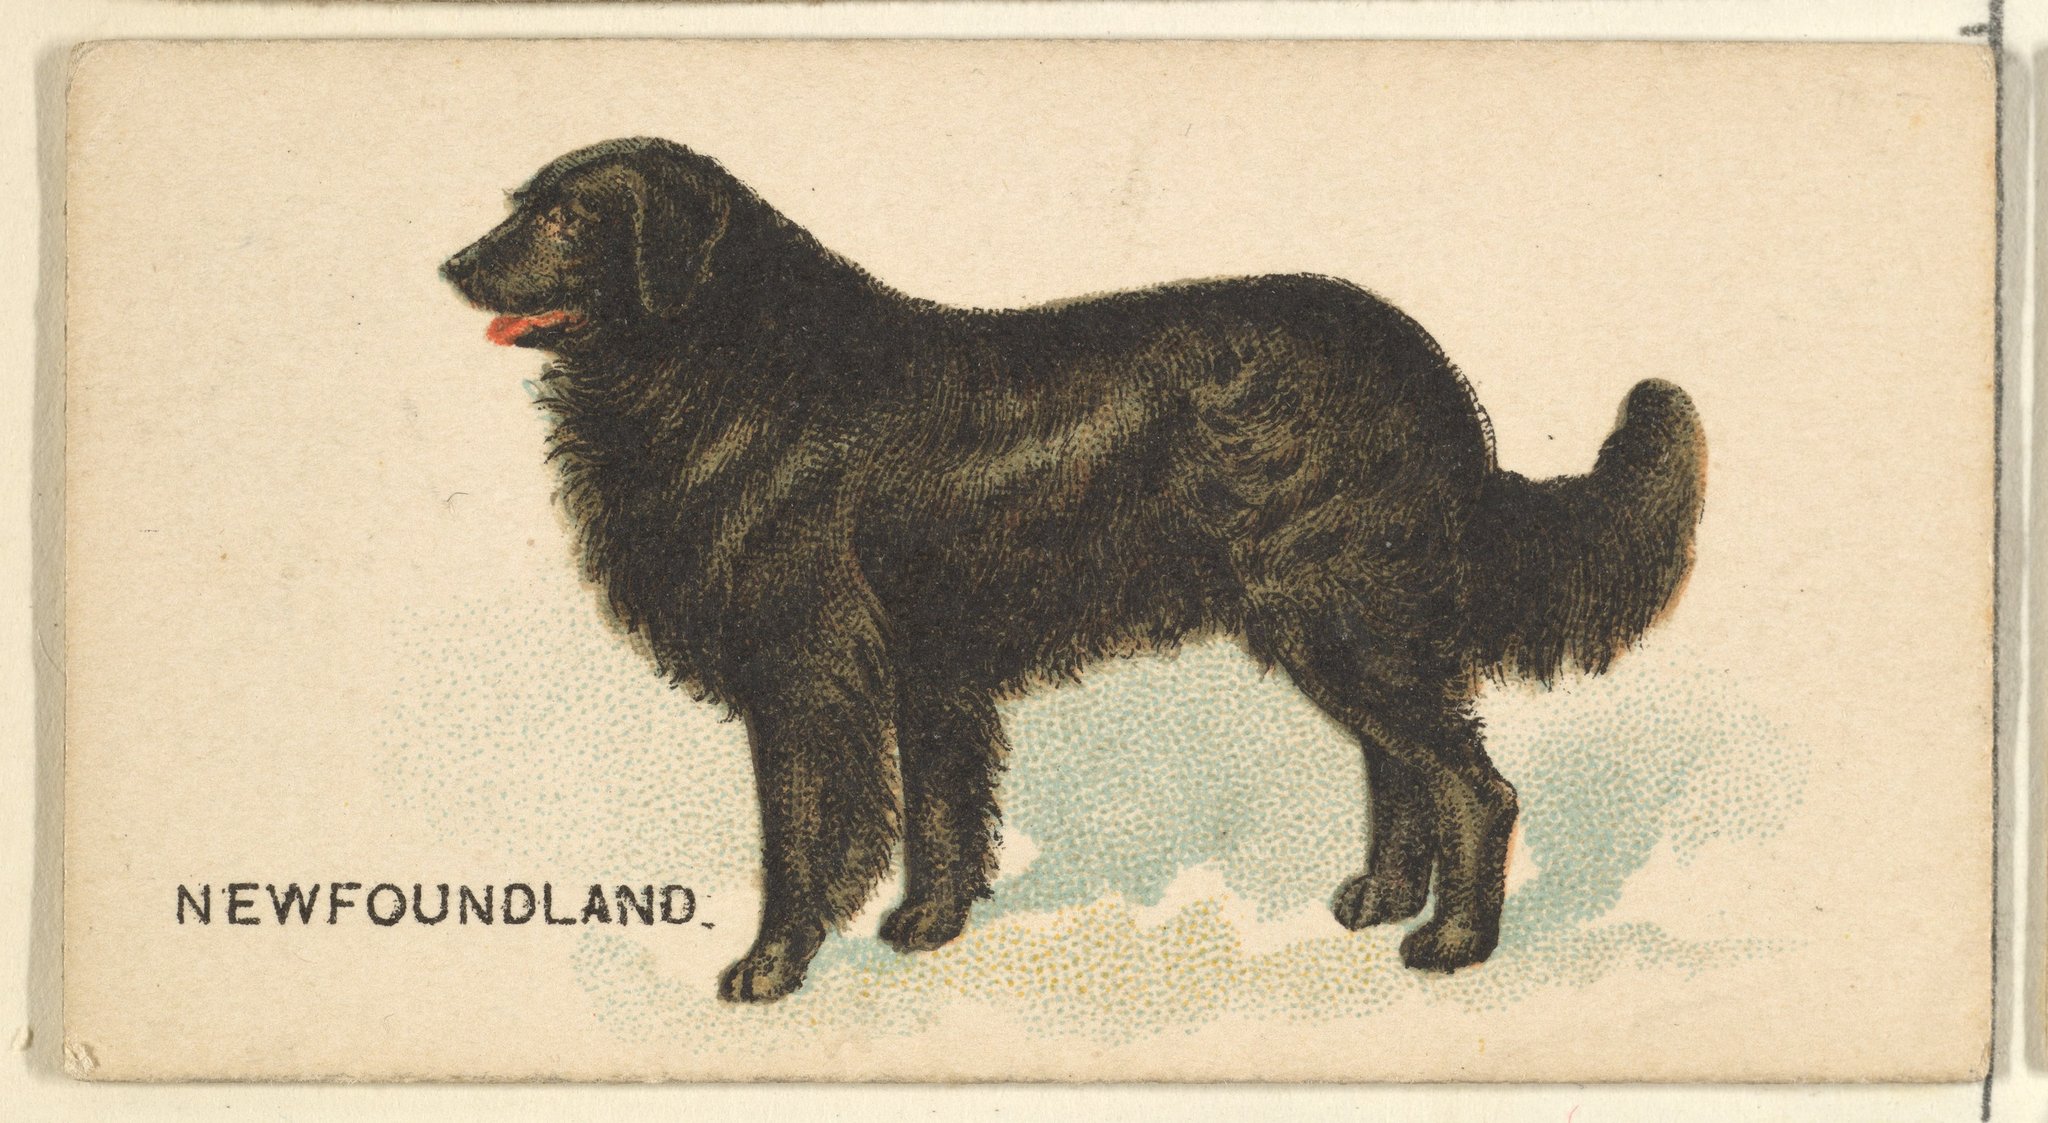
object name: print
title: Newfoundland, from the Dogs of the World series for Old Judge Cigarettes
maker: goodwin & company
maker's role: publisher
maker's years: 1850-1950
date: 1890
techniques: color lithograph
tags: dogs